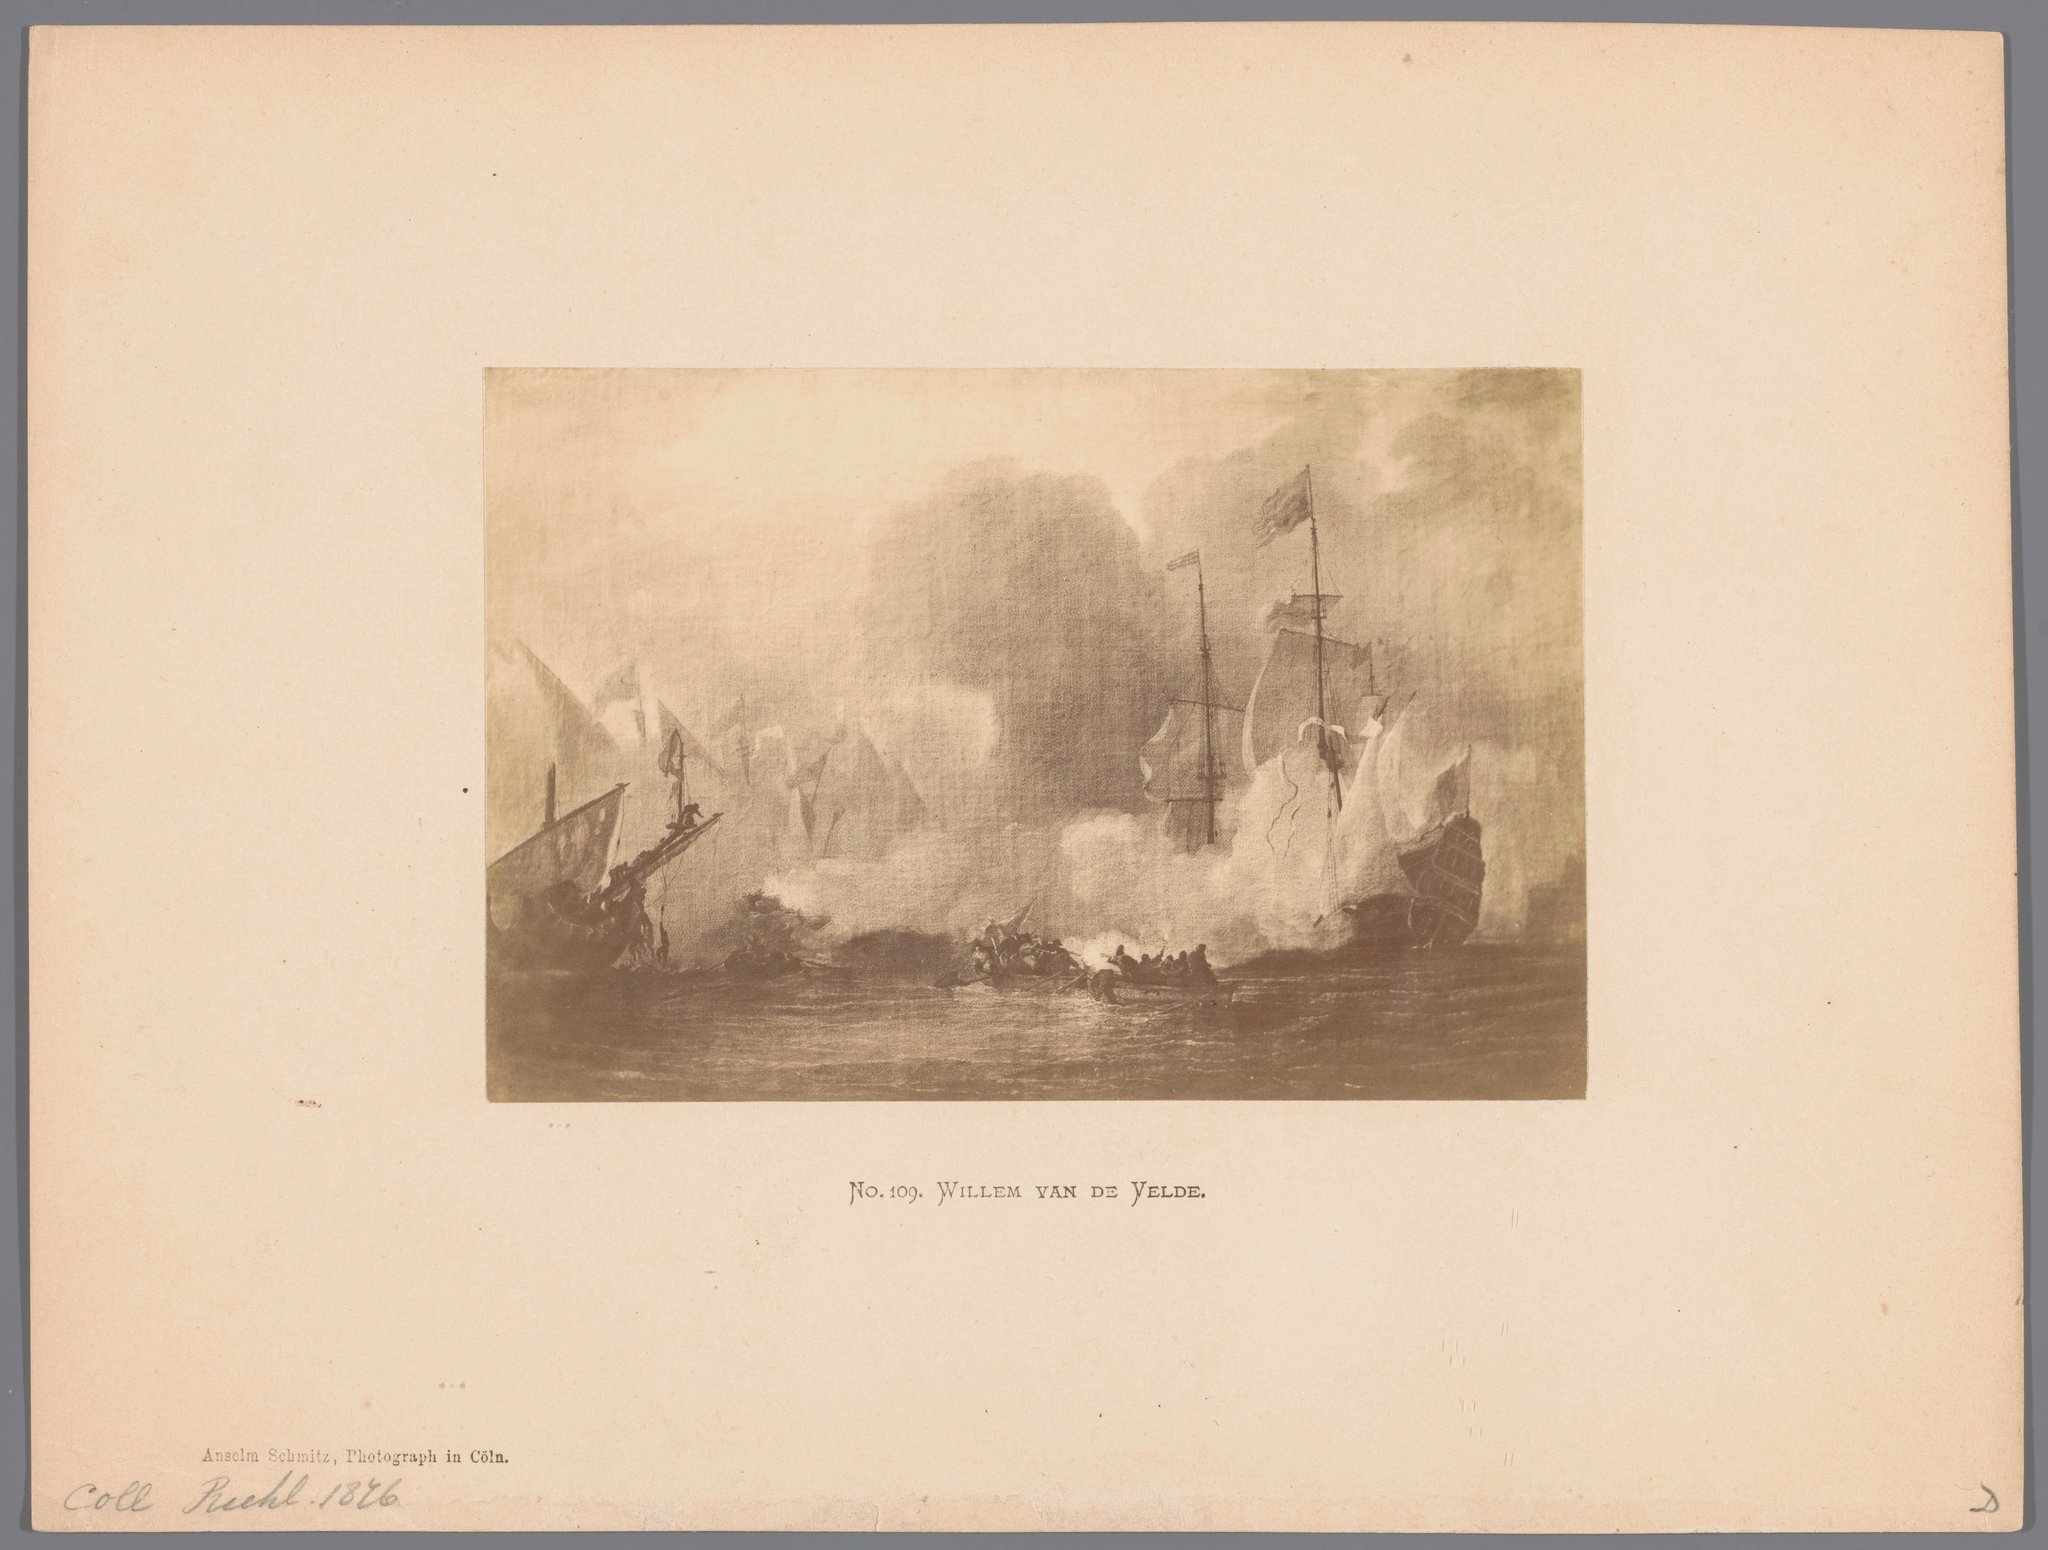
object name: photograph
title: Fotoreproductie van een schilderij van een zeeslag door Willem van de Velde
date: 1876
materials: cardboard, paper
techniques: albumen print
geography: cologne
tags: picture, painting, battle (+ sailing-ships), cologne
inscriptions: signature: ‘Anselm Schmitz, Photograph in Cöln’, inscription: ‘Coll. Ruhl. 1876’